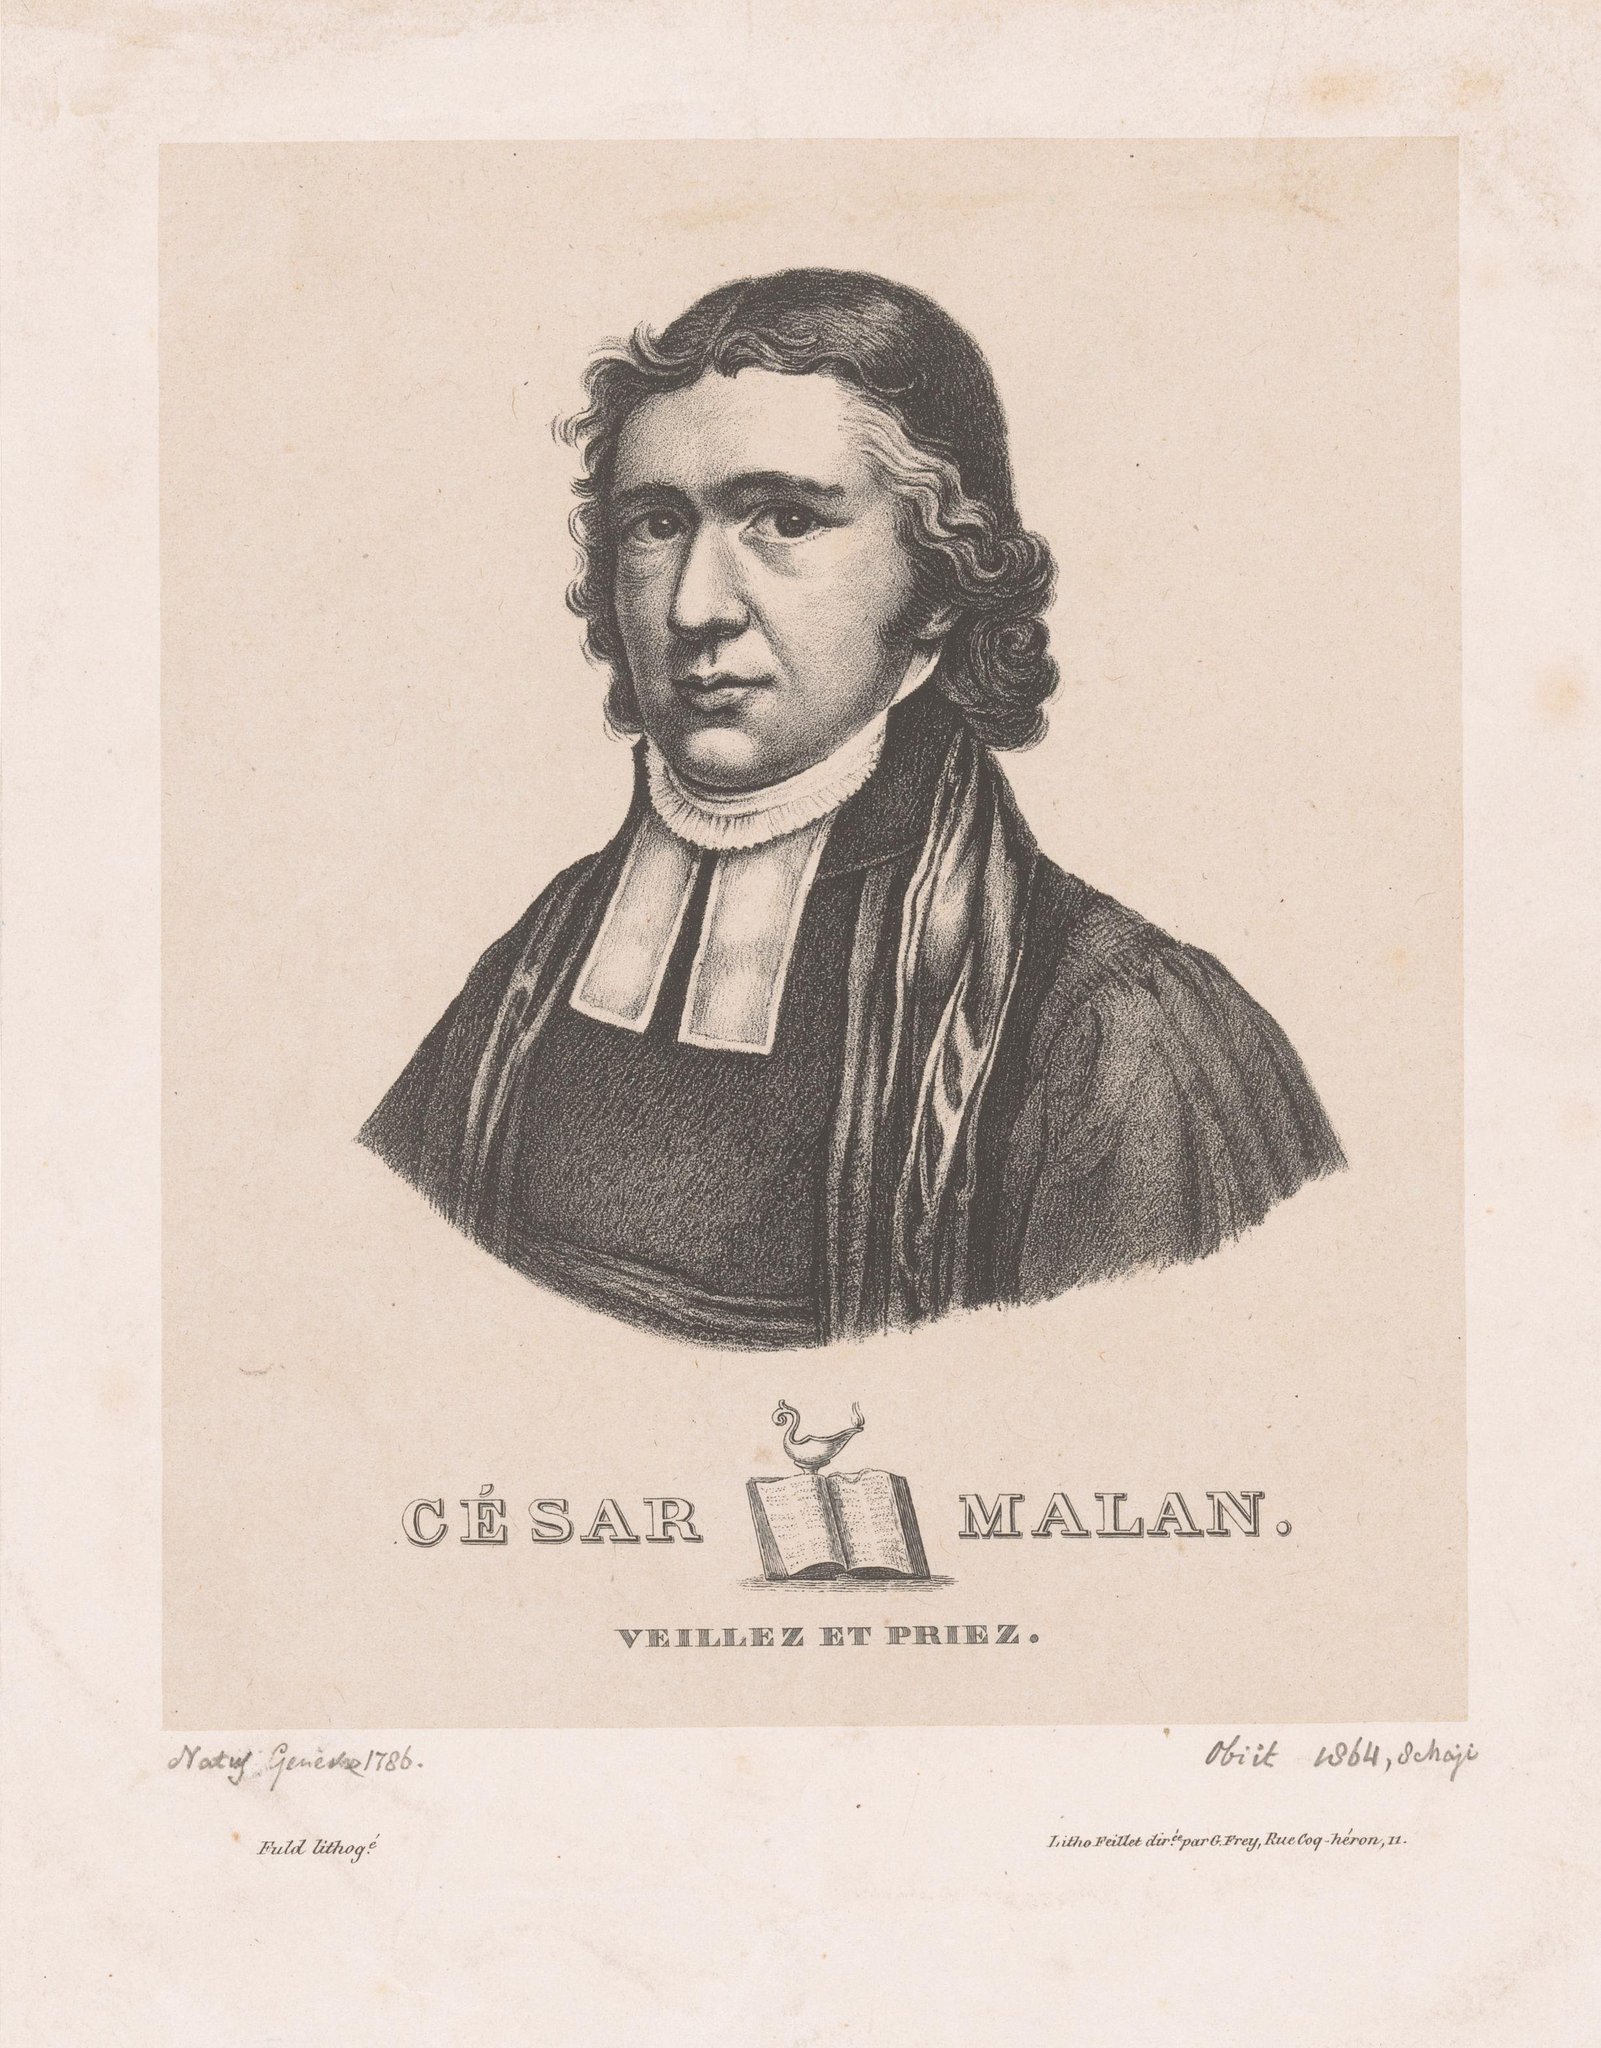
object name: print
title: César Malan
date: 1828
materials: paper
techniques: lithograph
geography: paris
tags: historical persons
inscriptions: collector's mark: Lugt 2228a